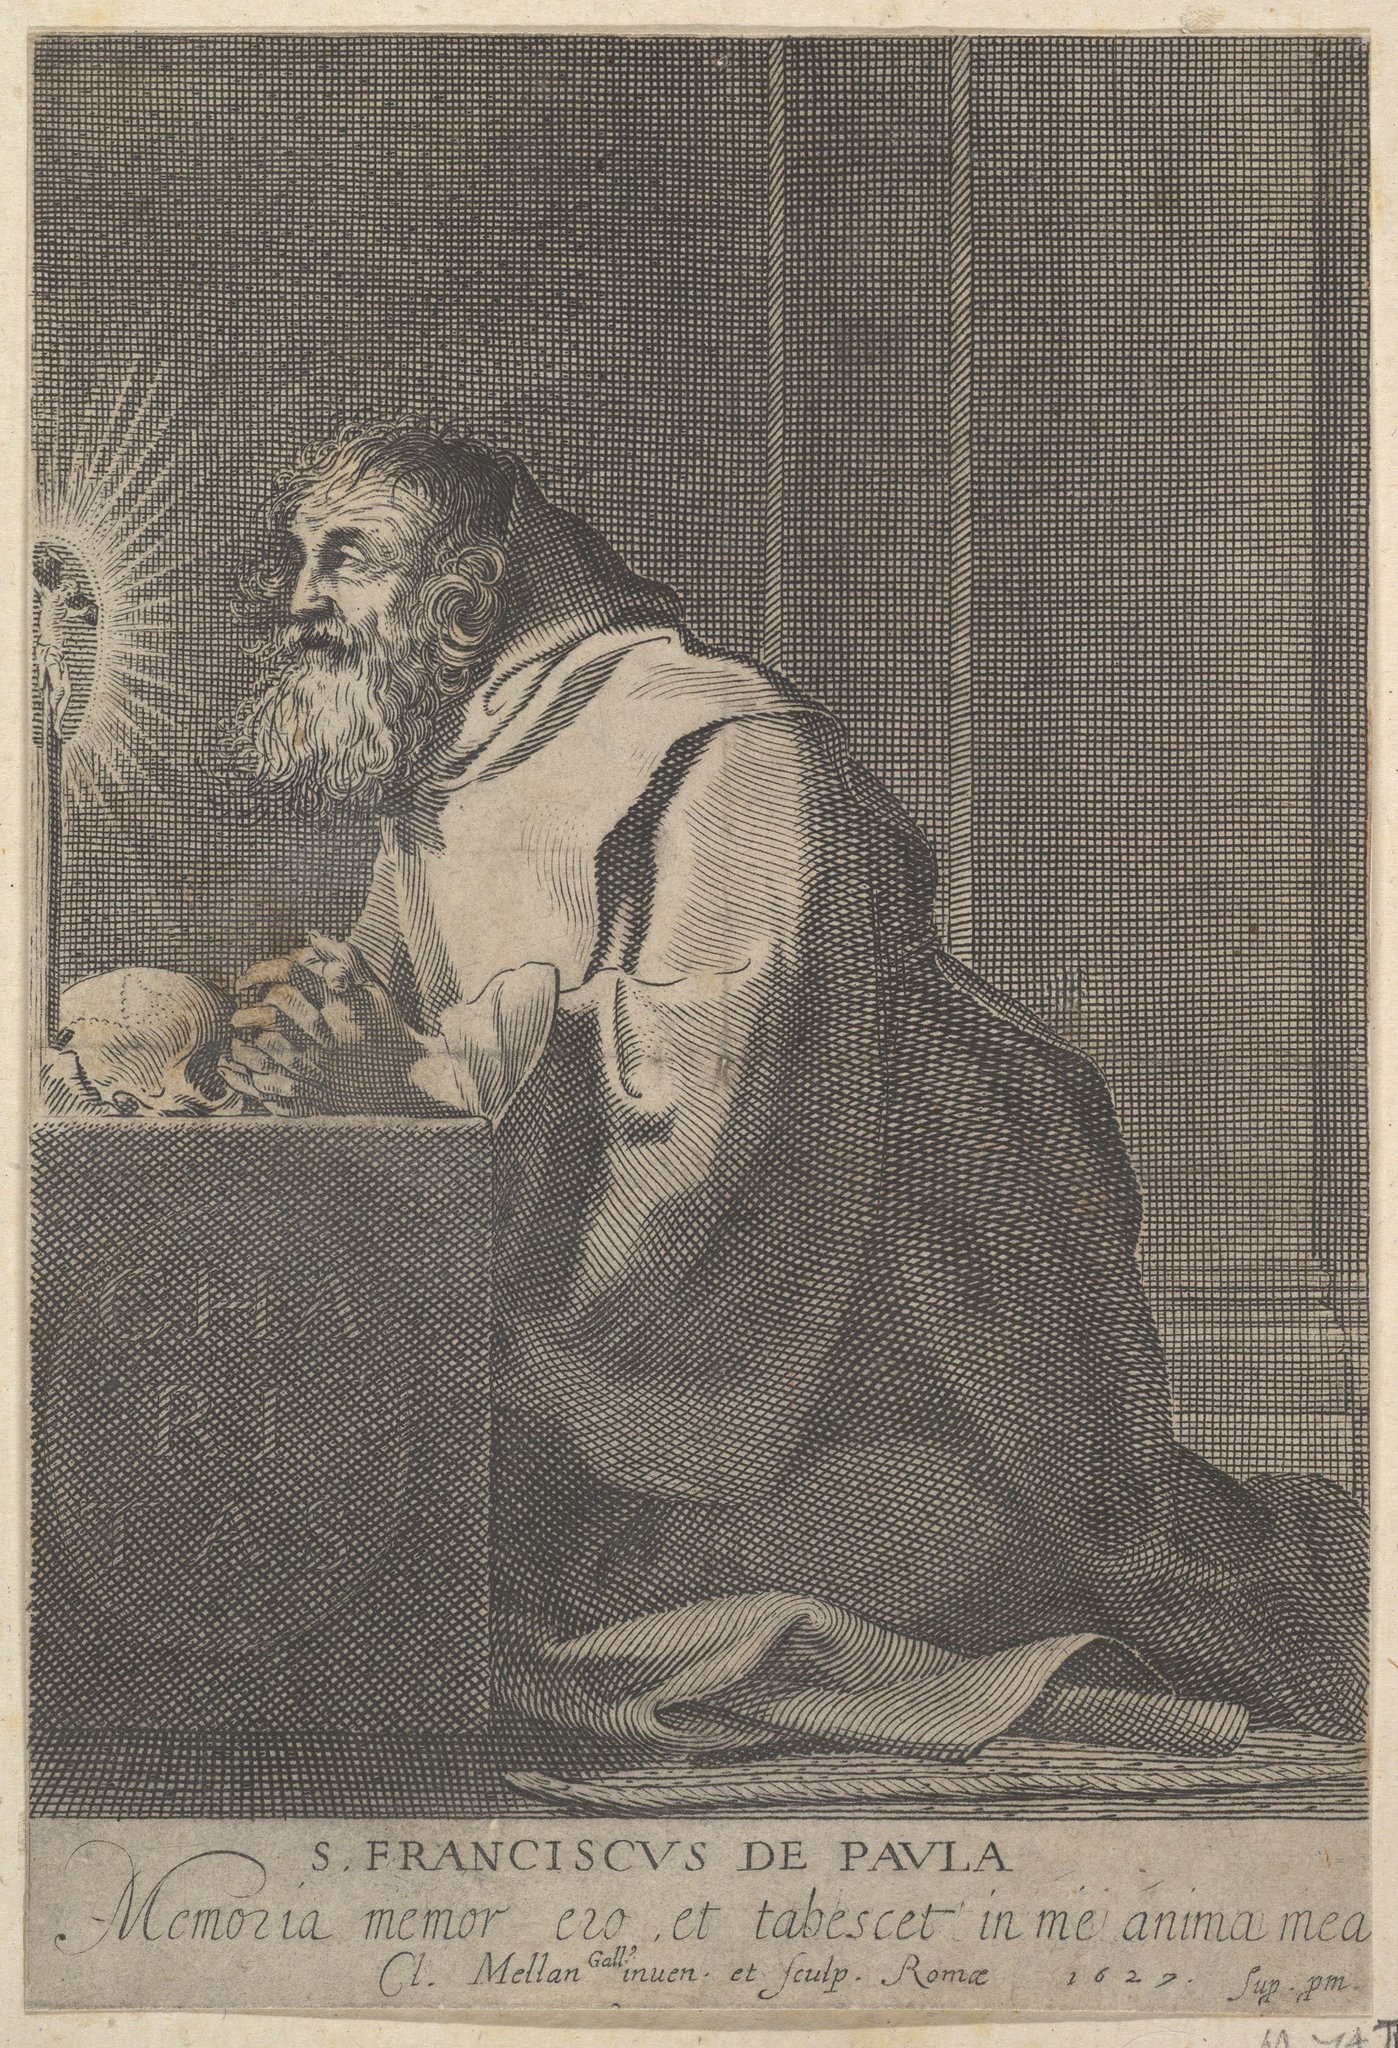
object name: print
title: St. Francis de Paul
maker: claude mellan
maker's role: artist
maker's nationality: french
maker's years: 1598-1688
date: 1627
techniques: engraving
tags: christ,saints